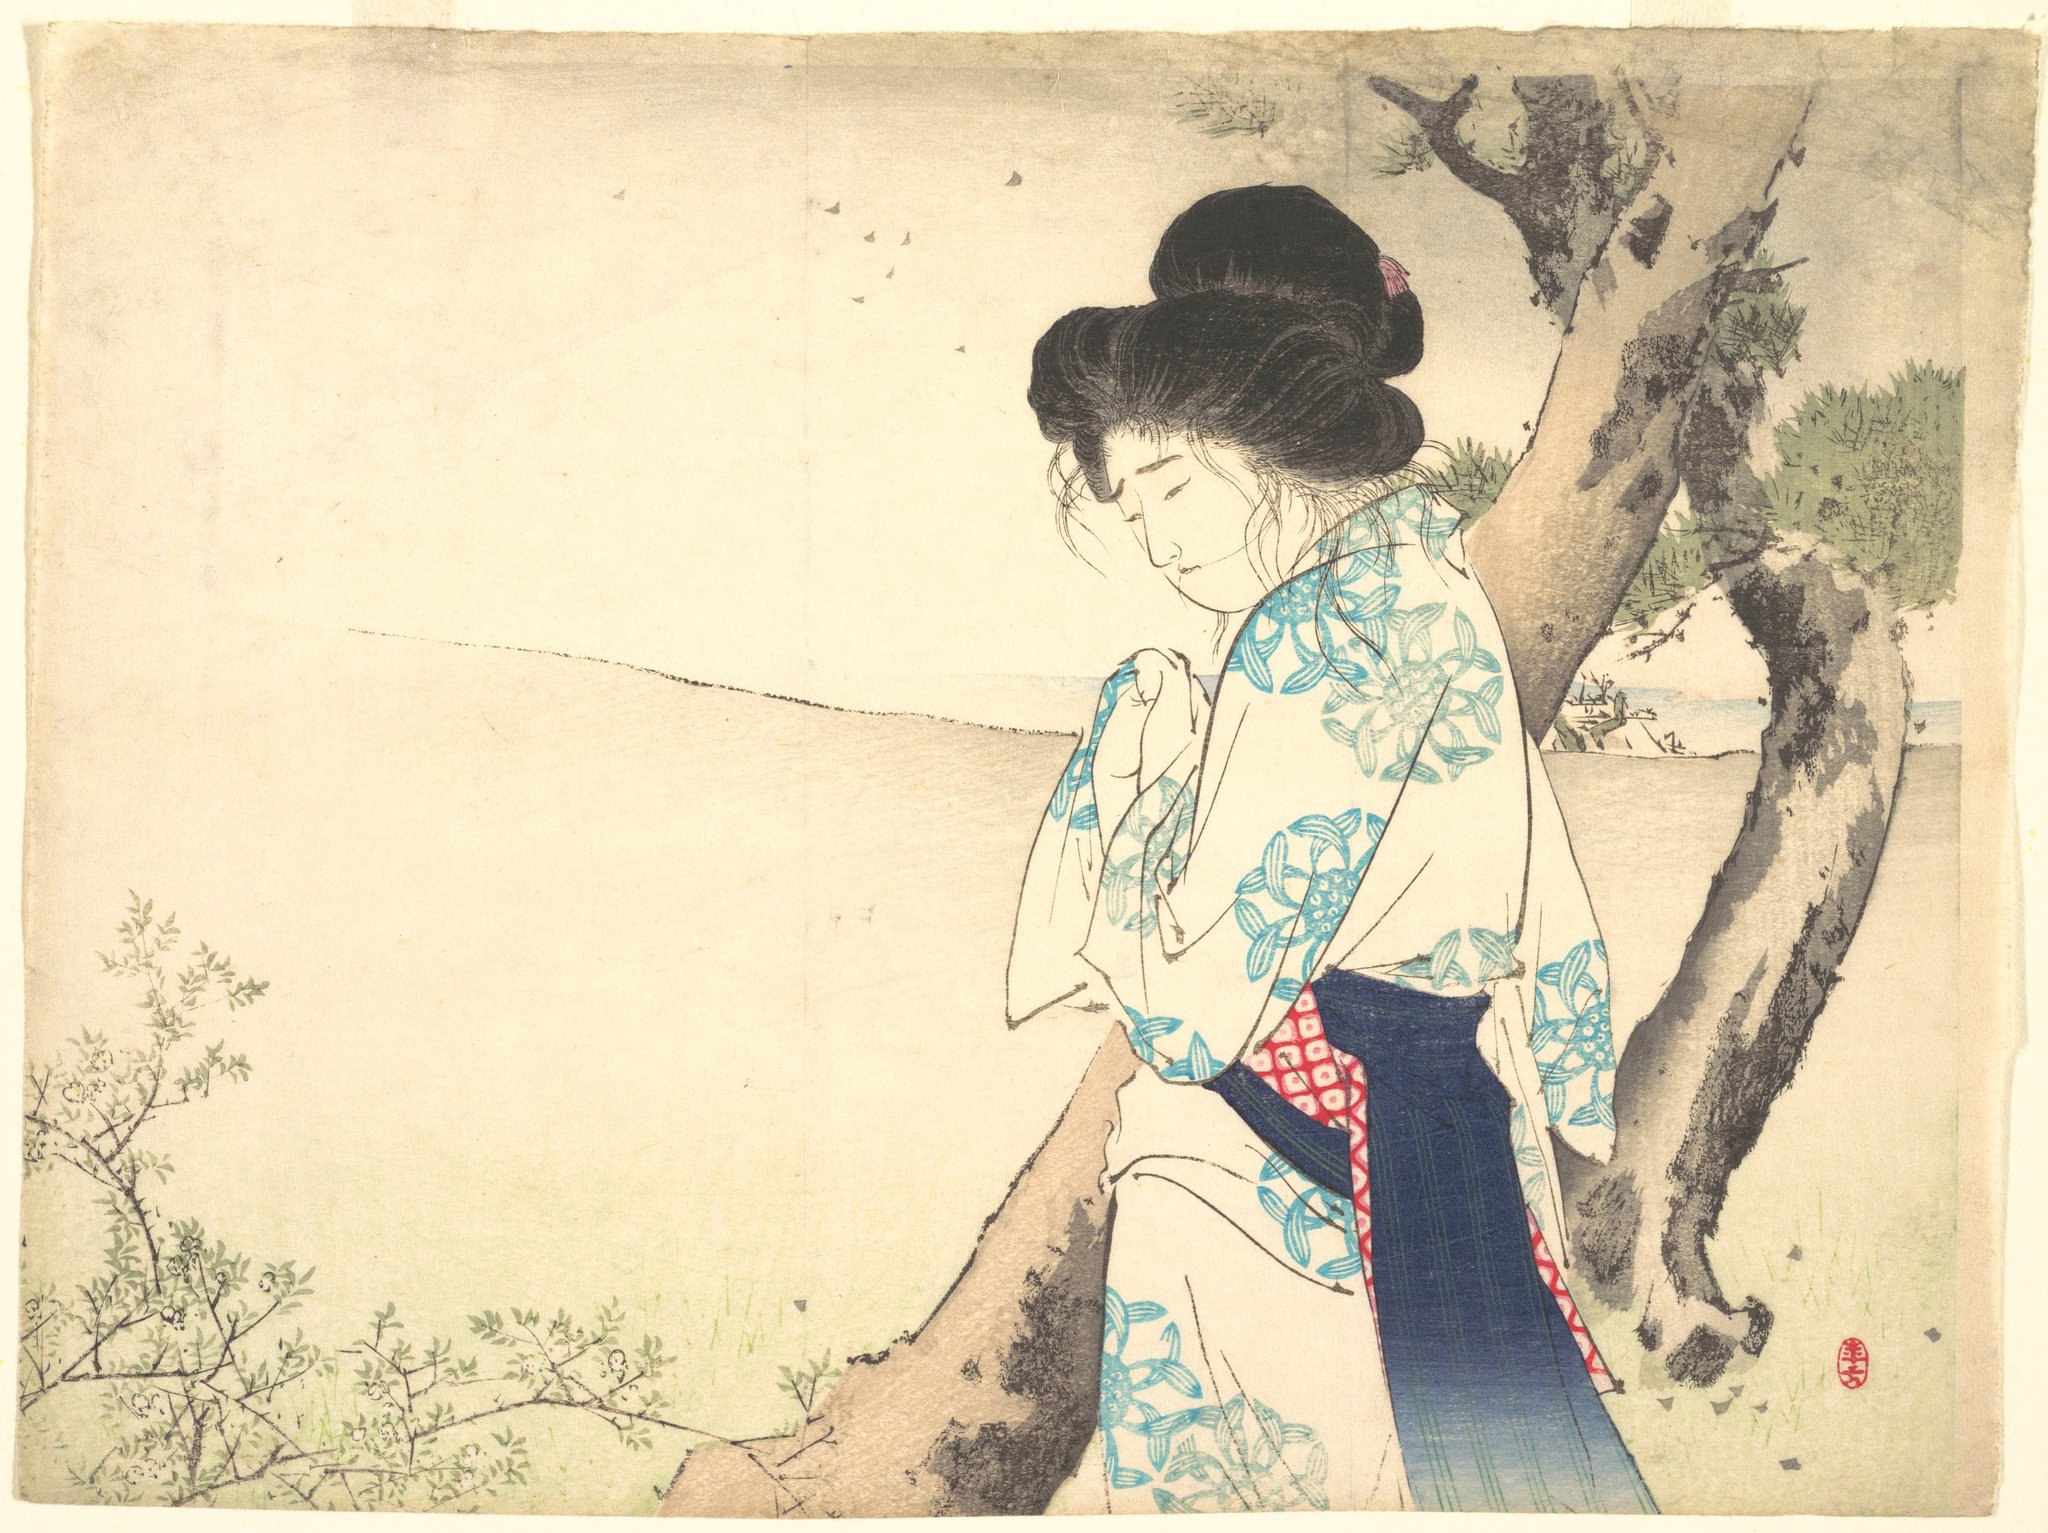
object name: print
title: The Mad Woman of Yawata (Yawata no kyōjo) from kuchie (frontispiece) of a novel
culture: japanese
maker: mizuno toshikata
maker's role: artist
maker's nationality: japanese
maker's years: 1866-1908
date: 1905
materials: ink, paper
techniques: woodblock print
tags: women,trees